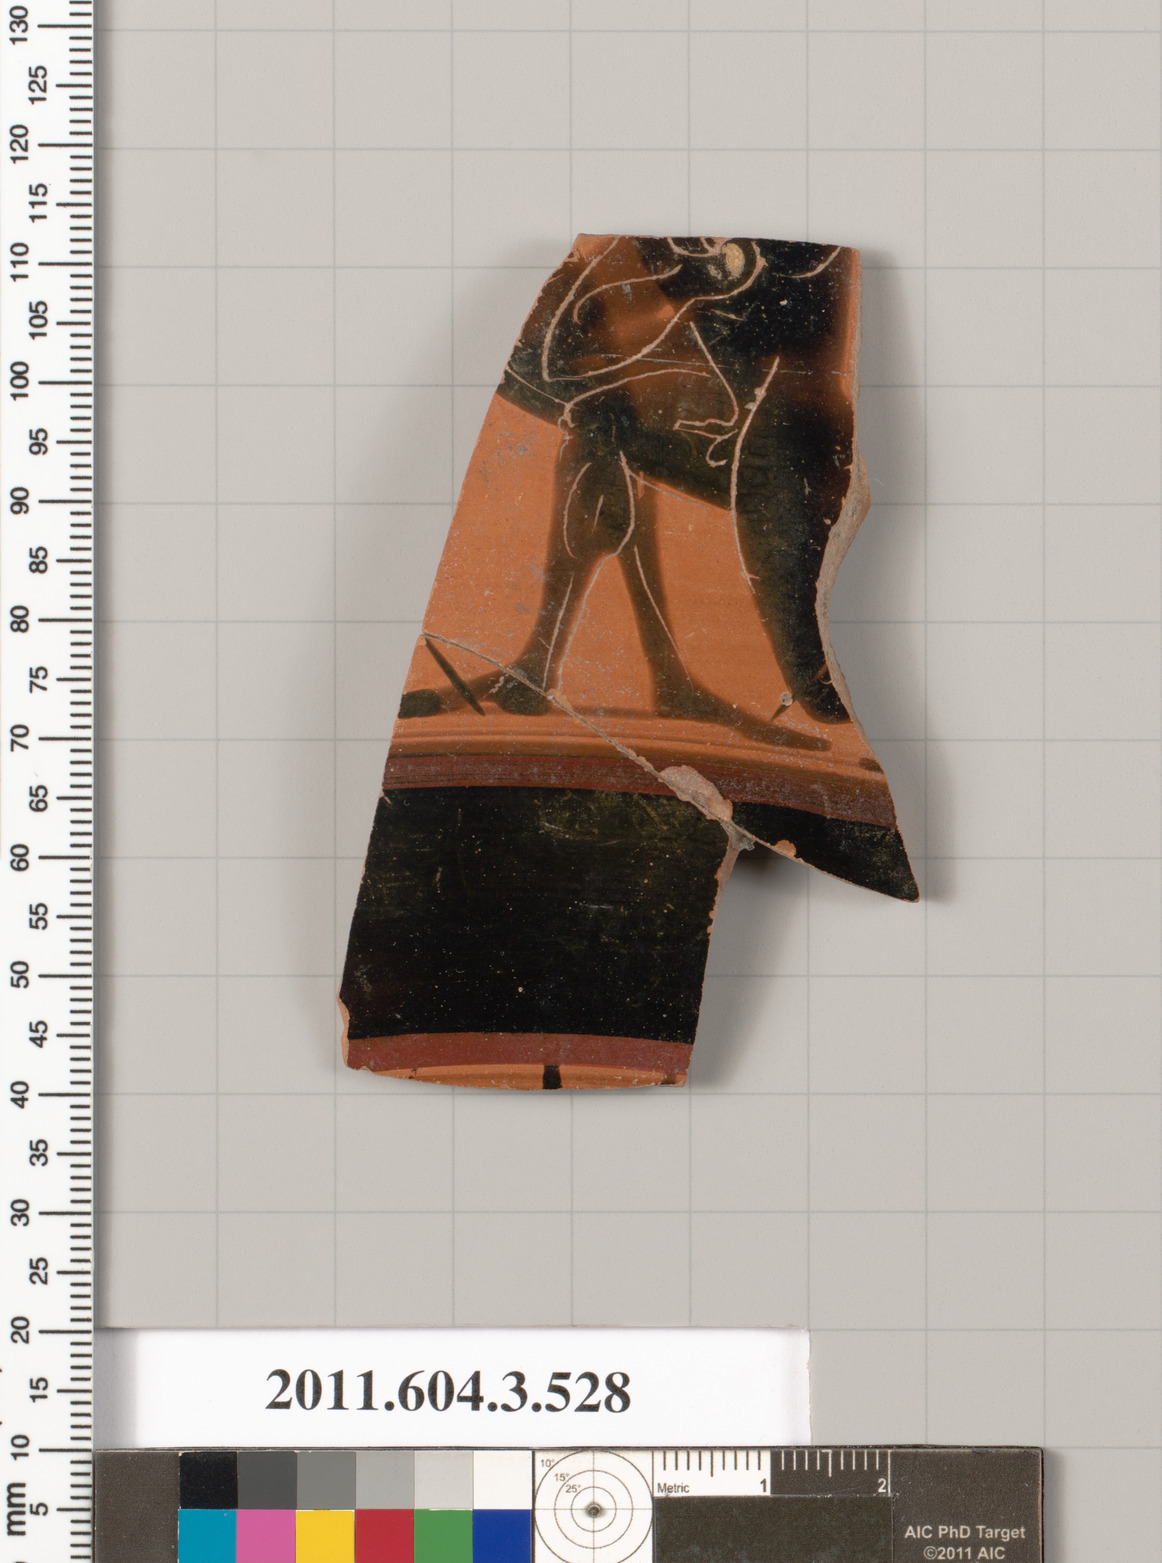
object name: column krater fragment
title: Terracotta fragment of a column-krater (bowl for mixing wine and water)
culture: greek, attic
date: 510-500 BCE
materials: terracotta